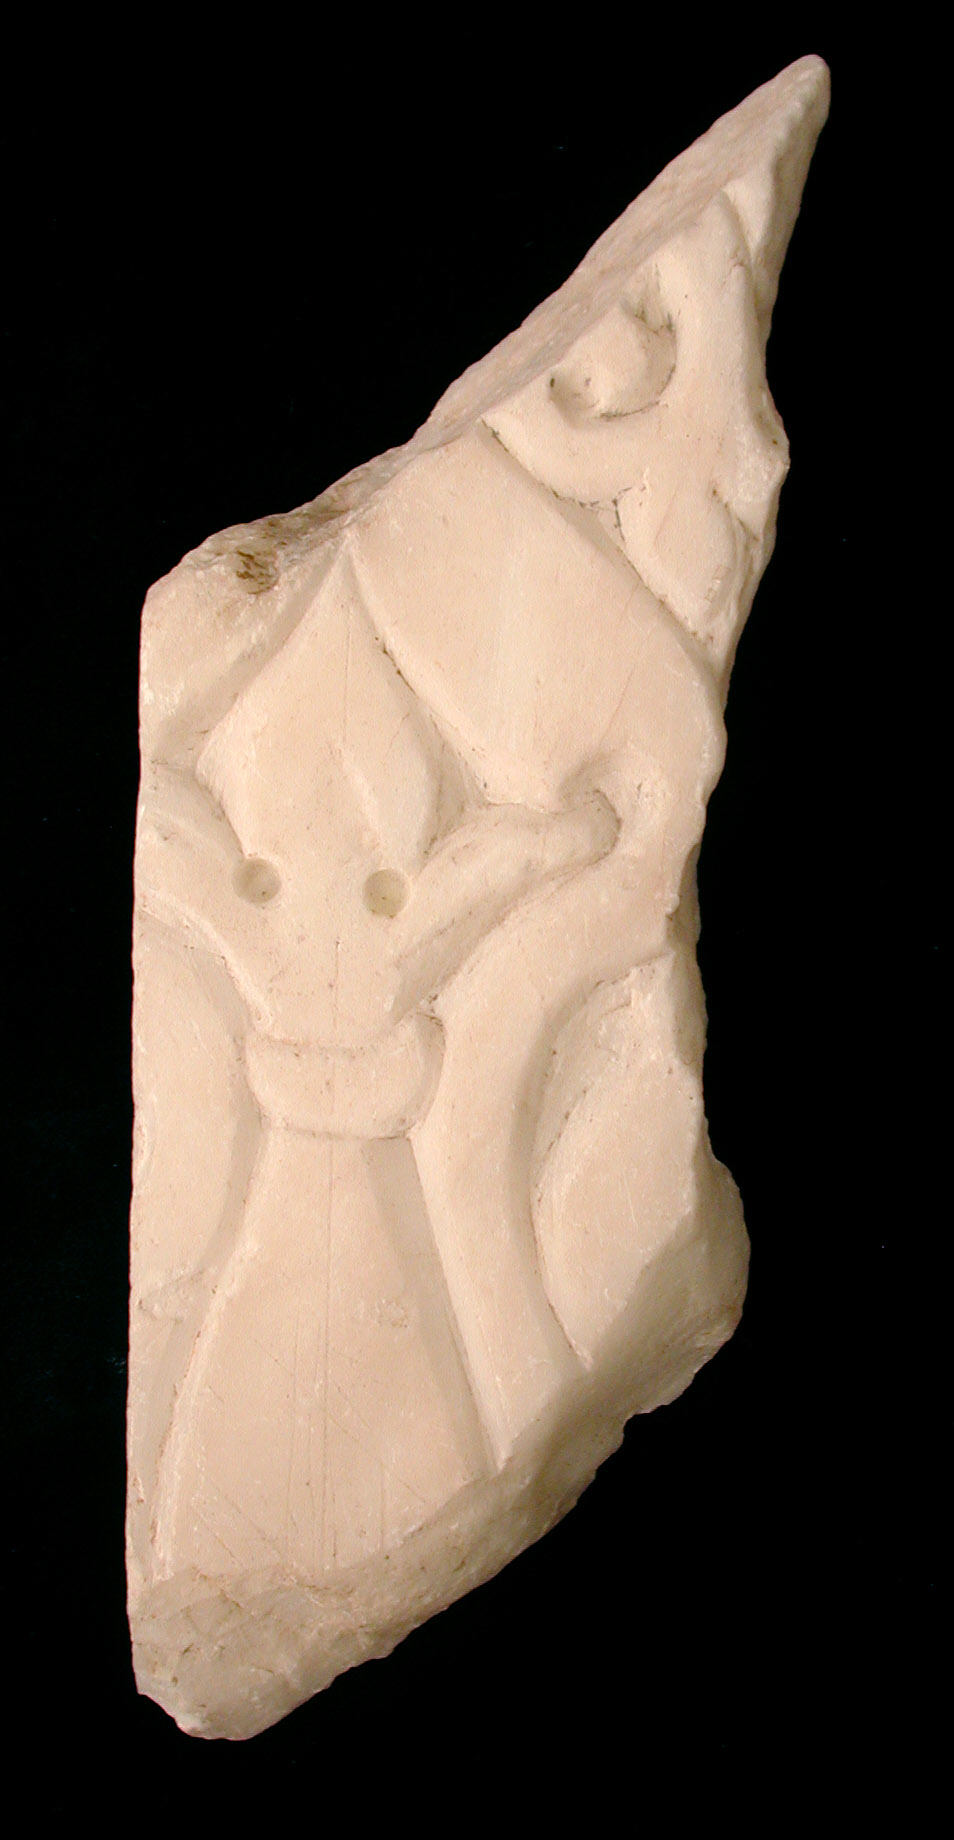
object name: fragment of a dado panel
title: Fragment of a Carved and Painted Dado Panel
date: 901-1100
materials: stone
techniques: carving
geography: iran